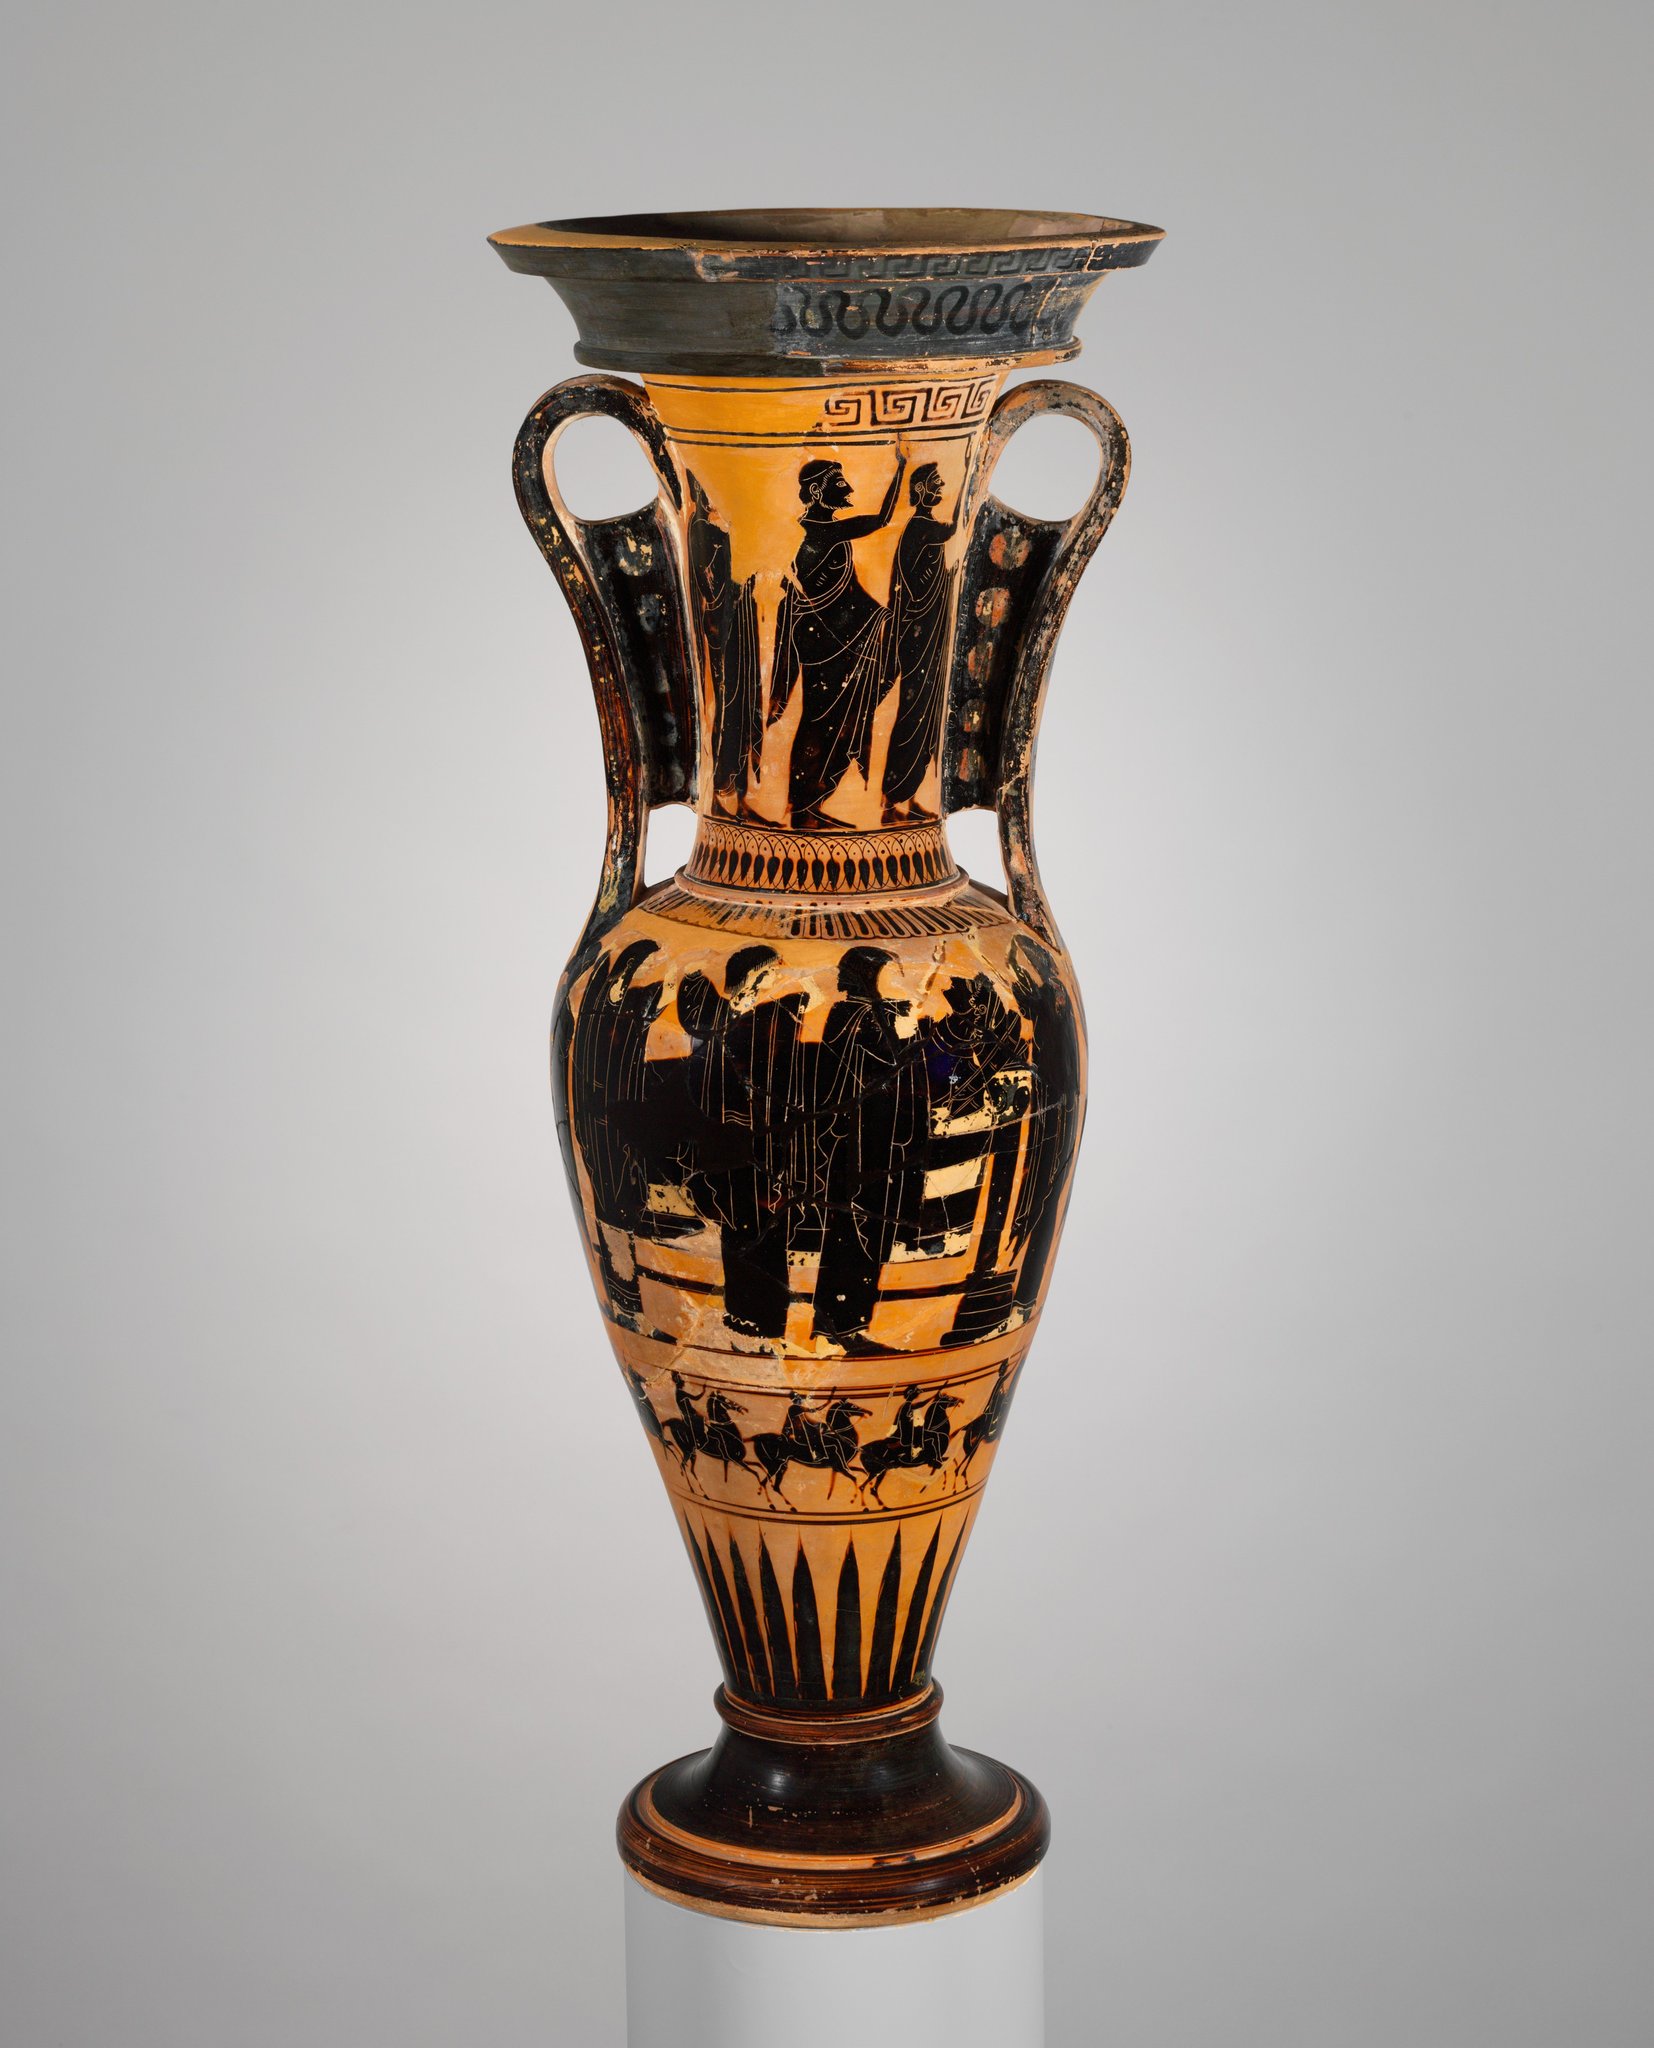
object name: loutrophoros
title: Terracotta loutrophoros (ceremonial vase for water)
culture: greek, attic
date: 525-501 BCE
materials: terracotta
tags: men,horses,funerals